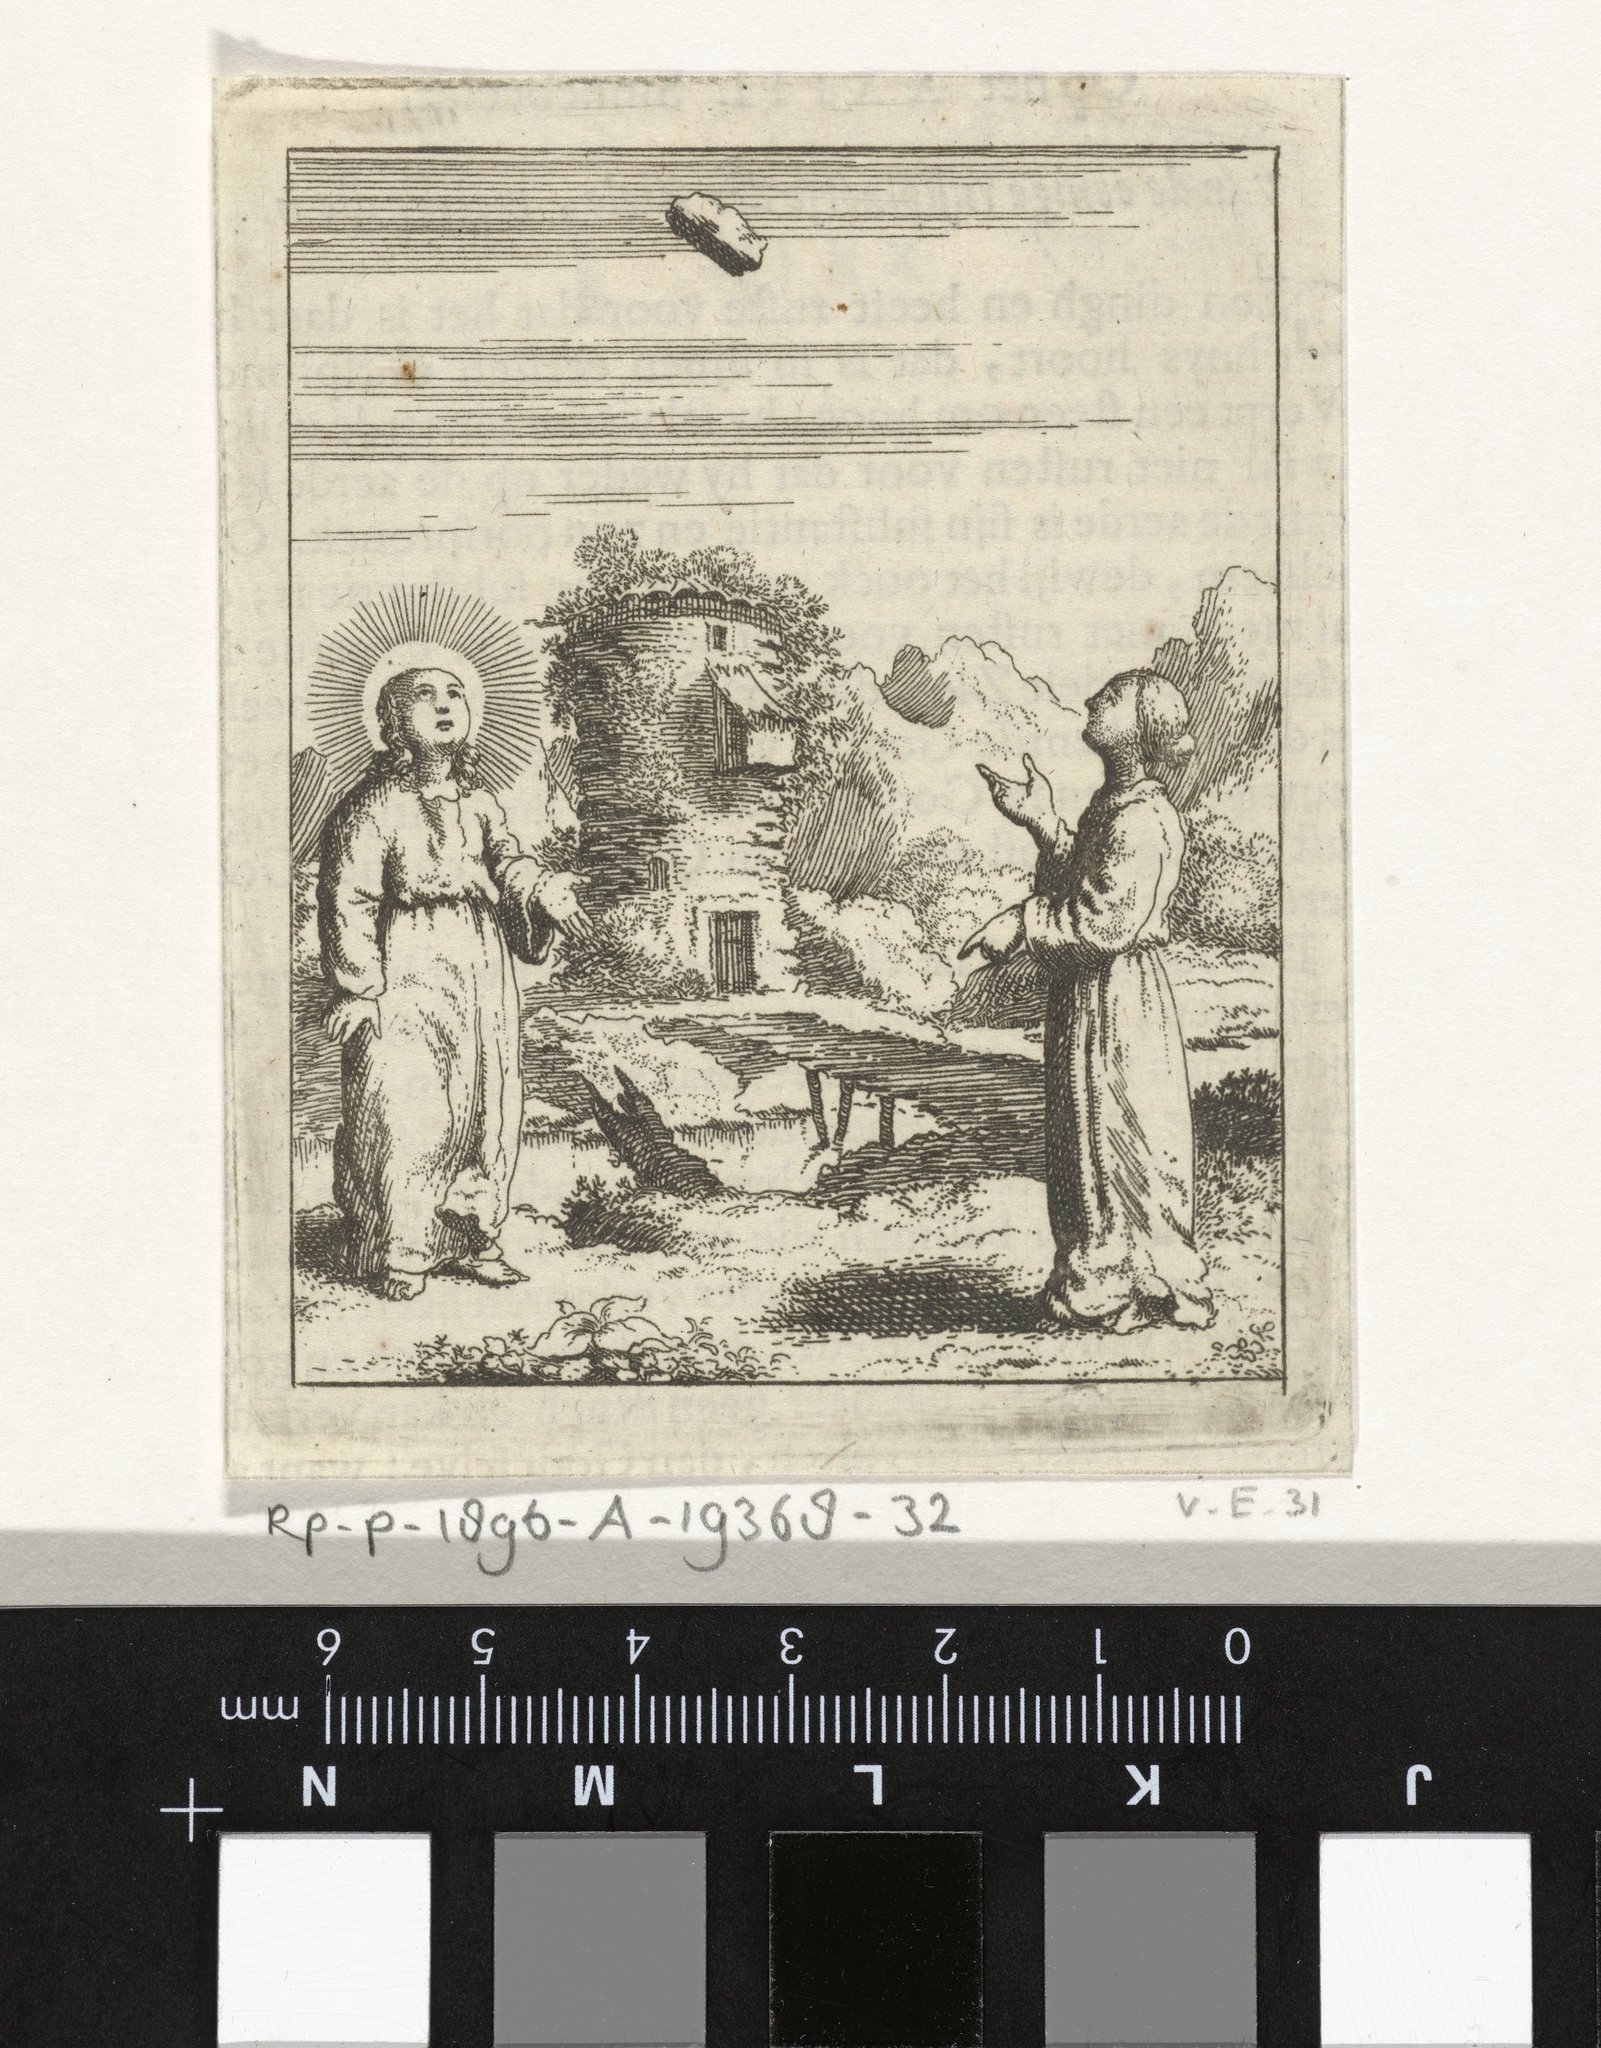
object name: print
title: Christus en de gepersonifieerde ziel aanschouwen een vallende steen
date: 1678-1687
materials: paper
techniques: etching, letterpress printing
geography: amsterdam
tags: smith, blacksmith (+ place ~ crafts, industries, agriculture)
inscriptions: collector's mark: Lugt 2228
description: Illustratie uit: Luyken, Jan. Jezus en de Ziel, 3 delen. Amsterdam: Pieter Arentsz II, 1678-1687. Tussen 1678-1744 verschenen van dit emblemataboek 10 edities.